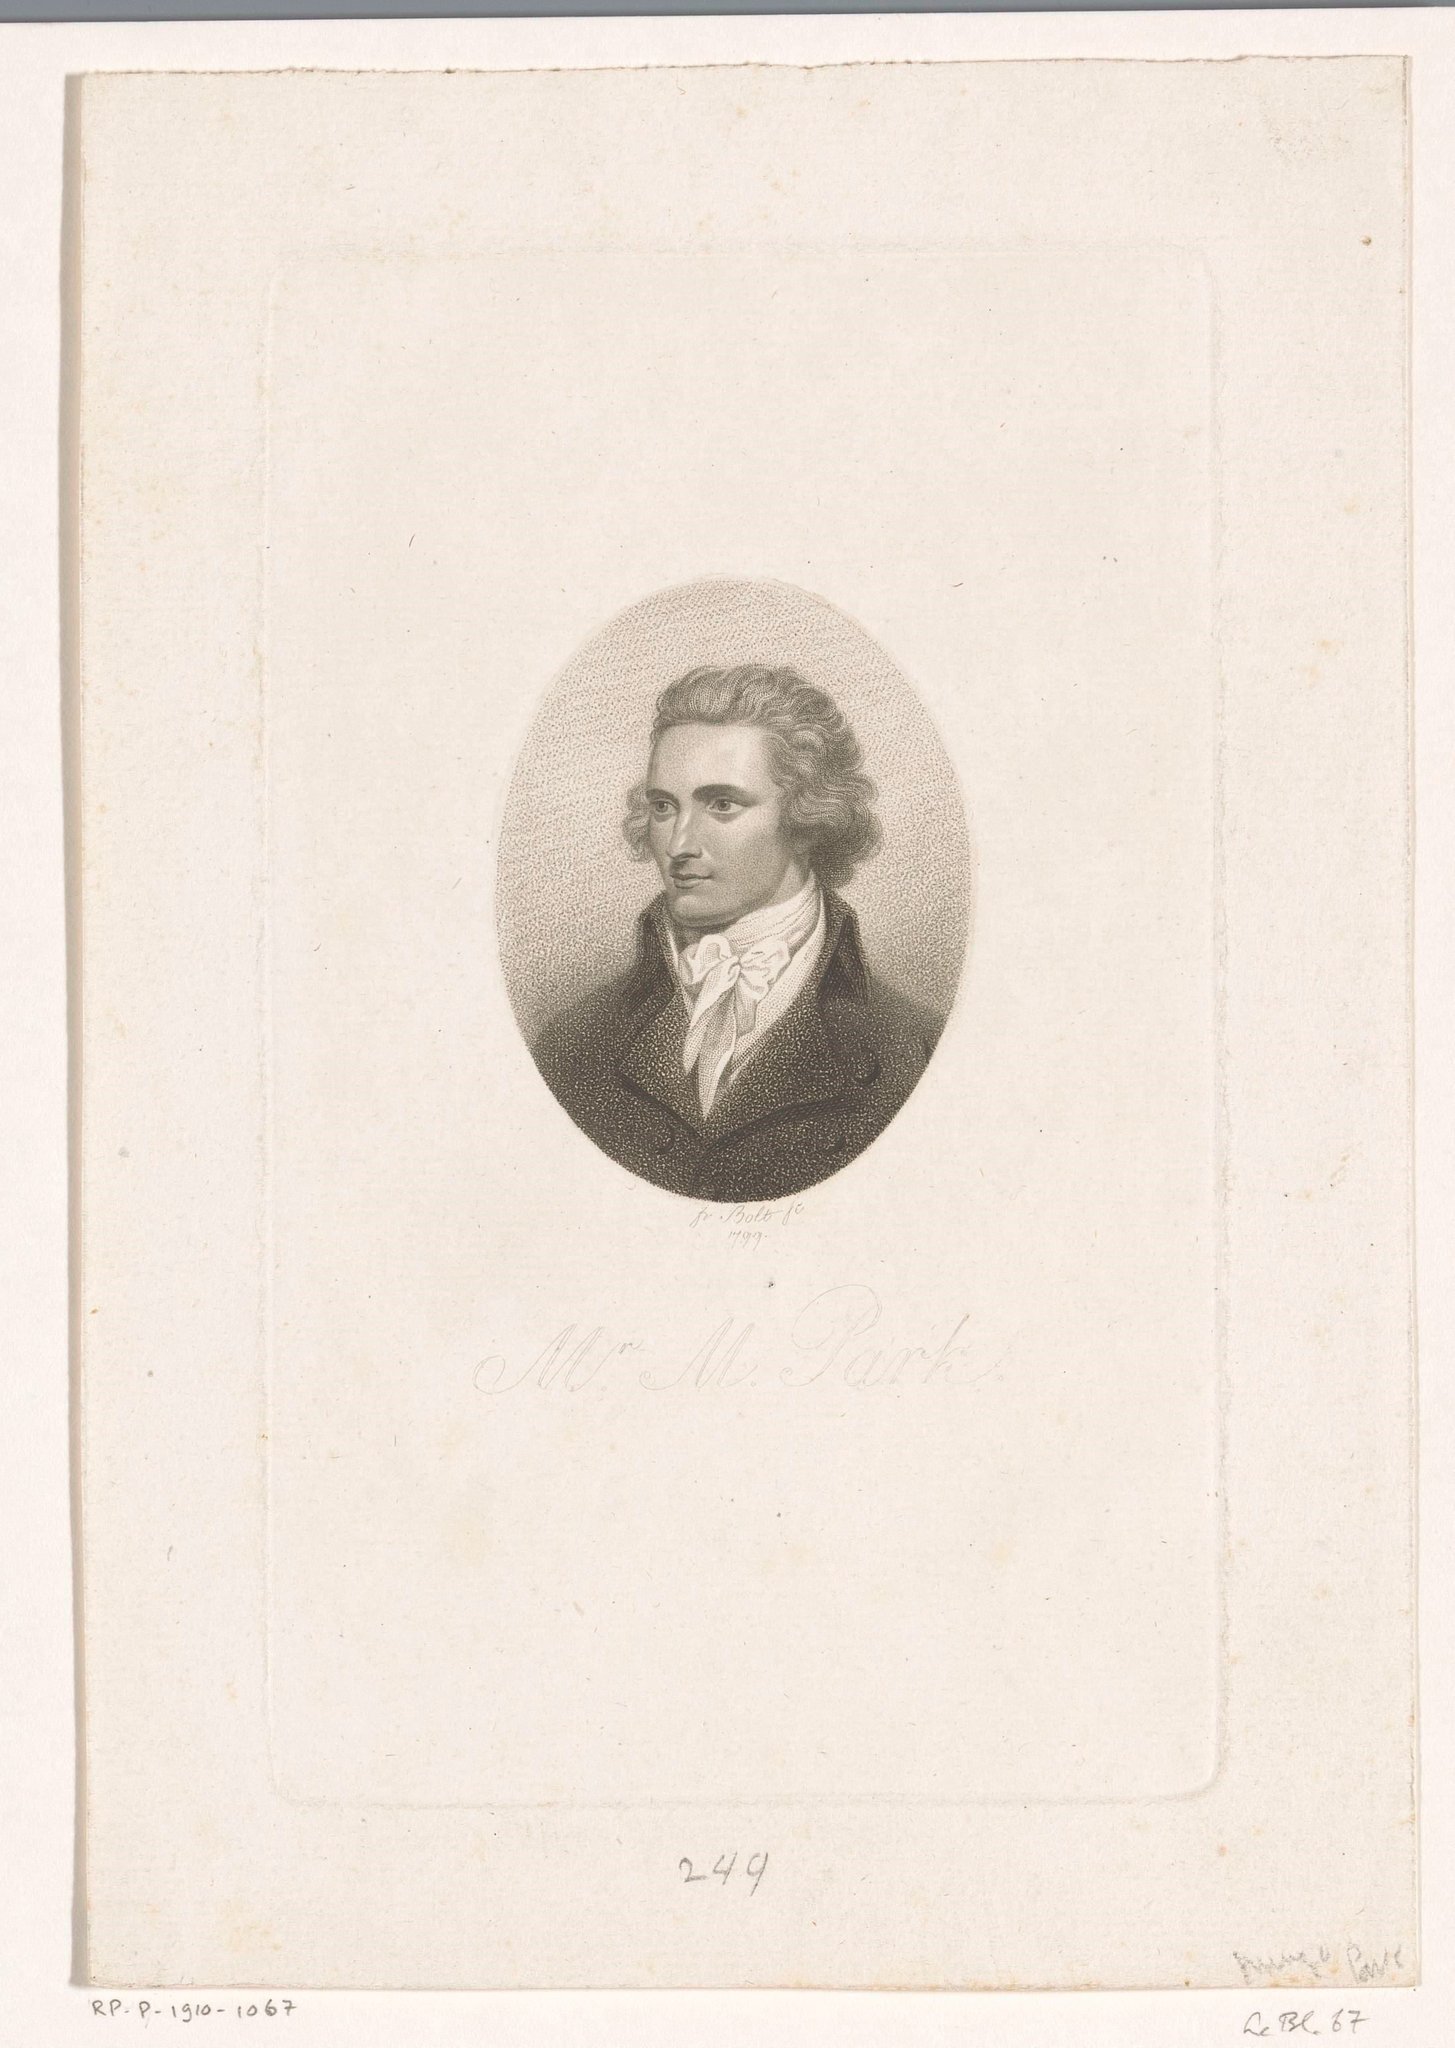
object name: print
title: Portret van Mungo Park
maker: johann friedrich bolt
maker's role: print maker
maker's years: 1769-1836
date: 1799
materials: paper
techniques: stippling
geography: berlin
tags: historical persons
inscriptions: collector's mark: Lugt 2228